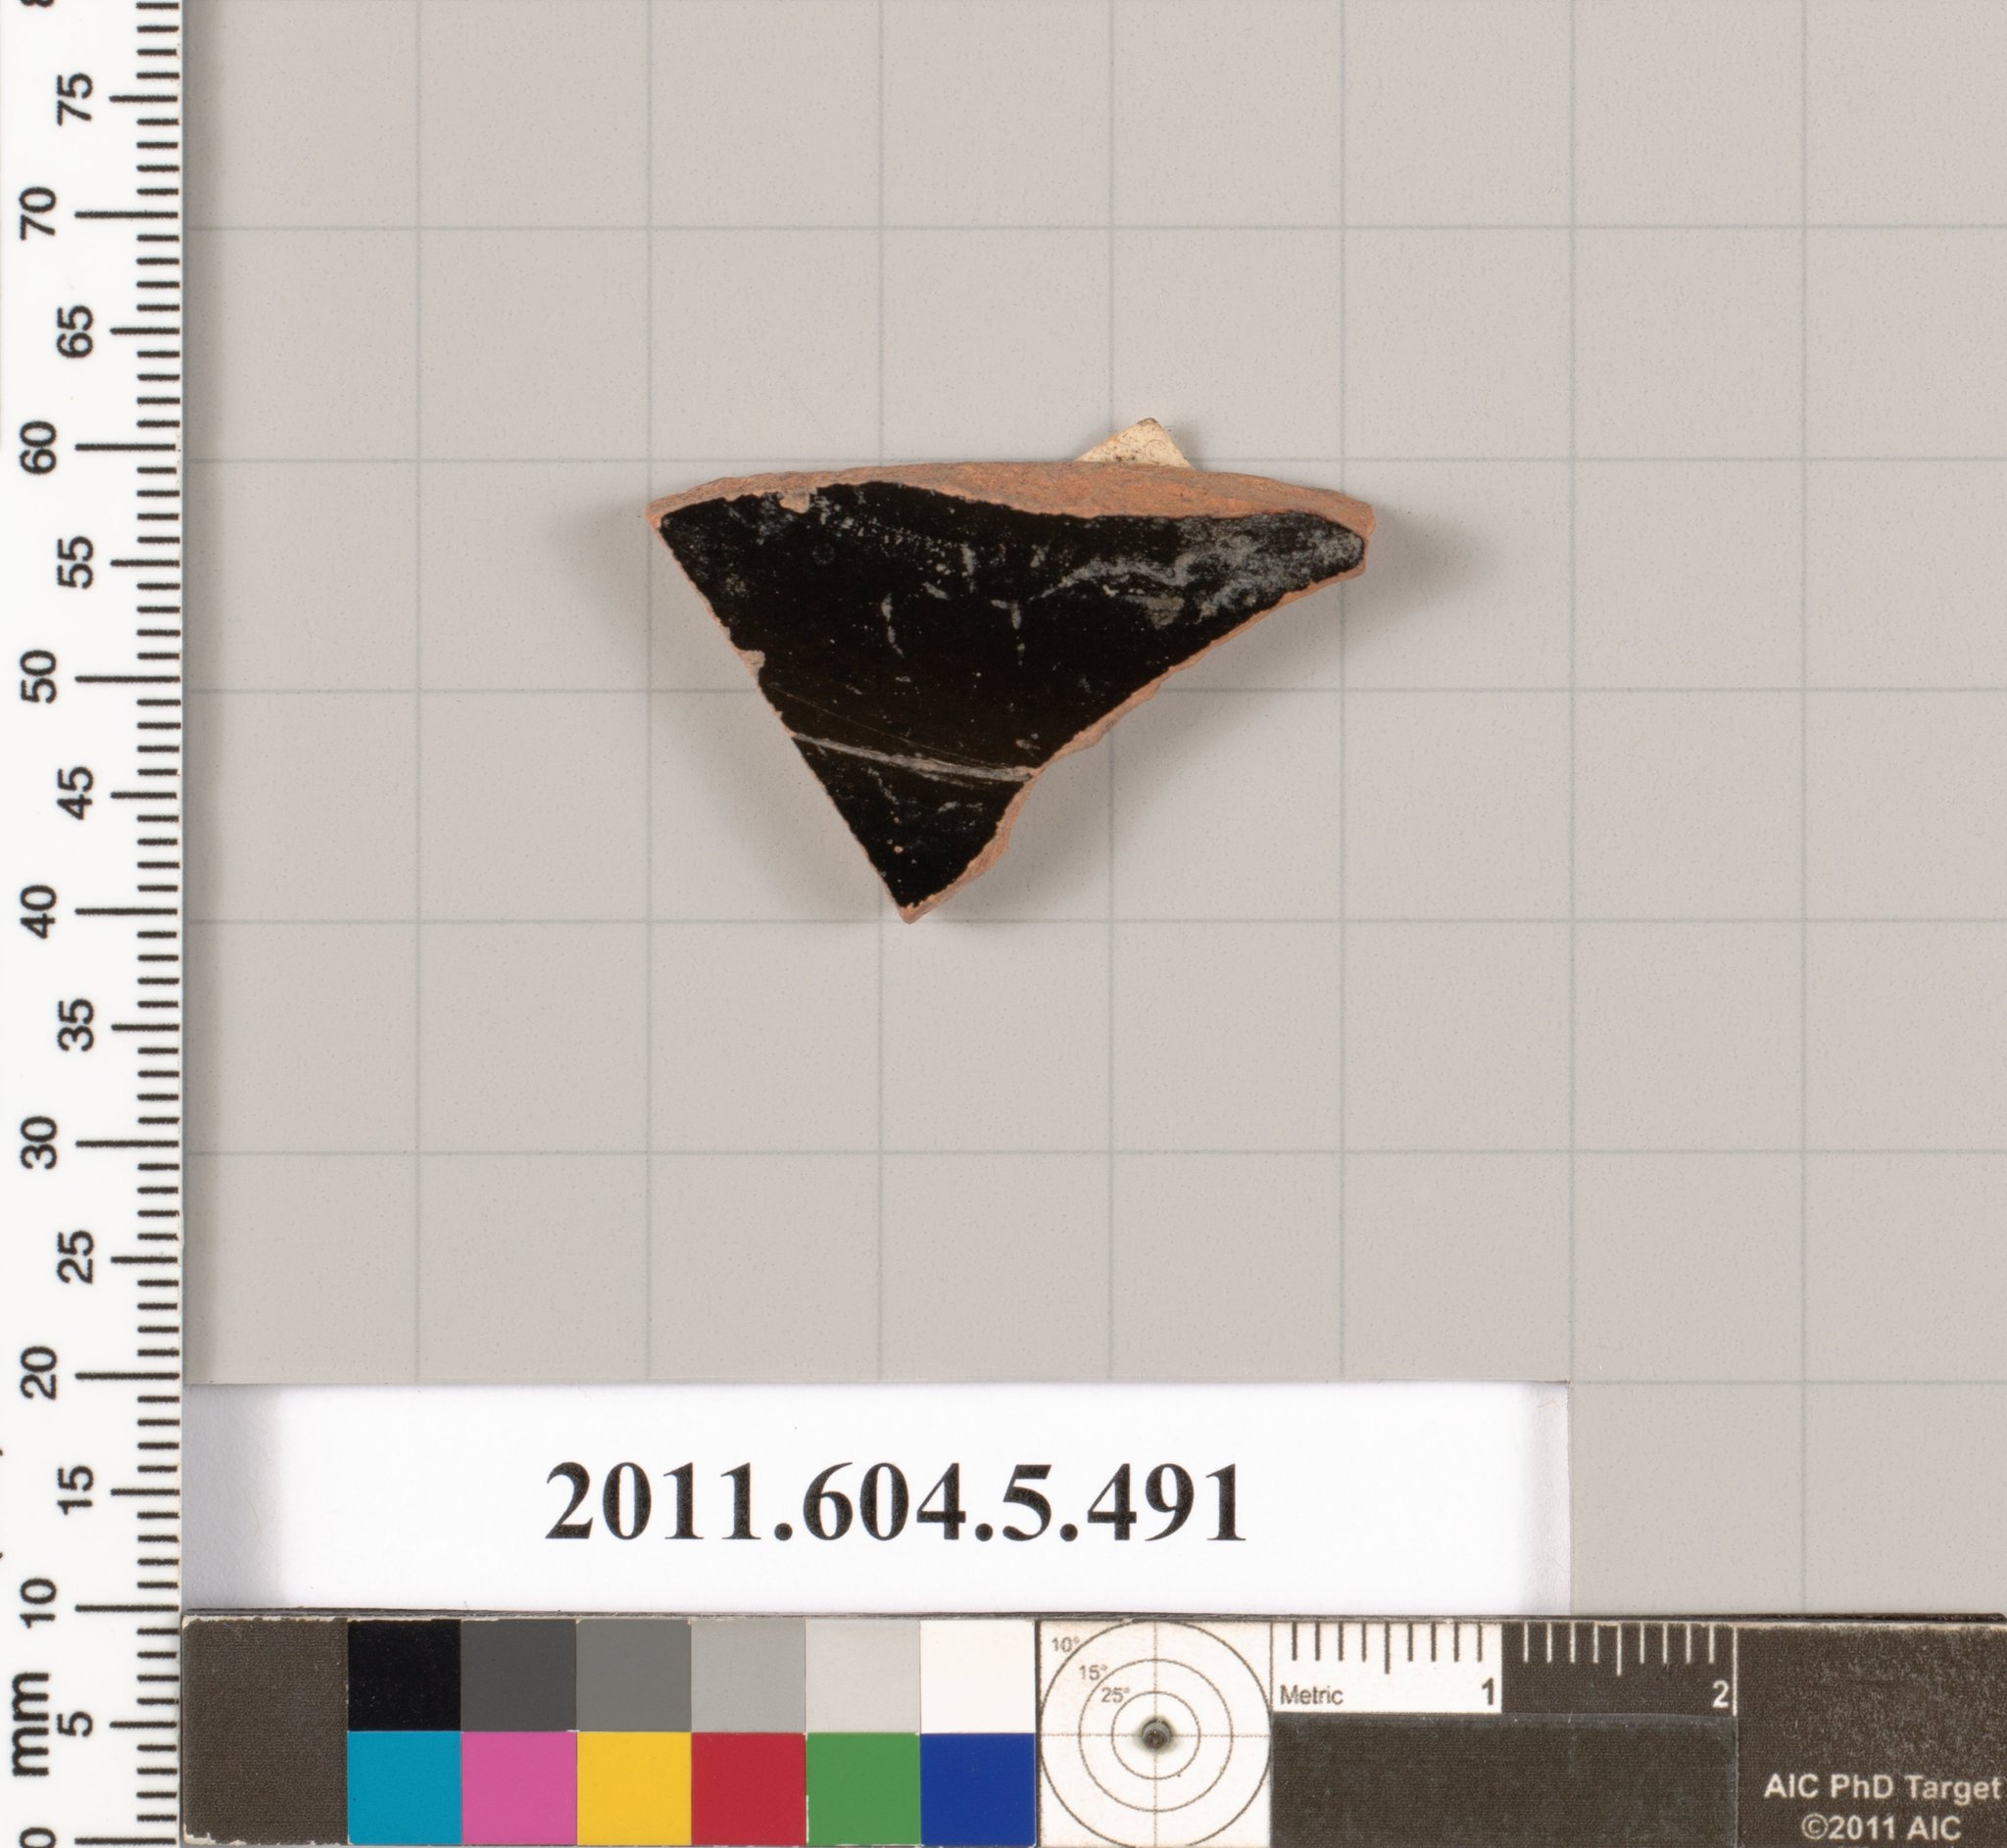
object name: kylix fragment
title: Terracotta fragment of a kylix (drinking cup)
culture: greek, attic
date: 600-401 BCE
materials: terracotta